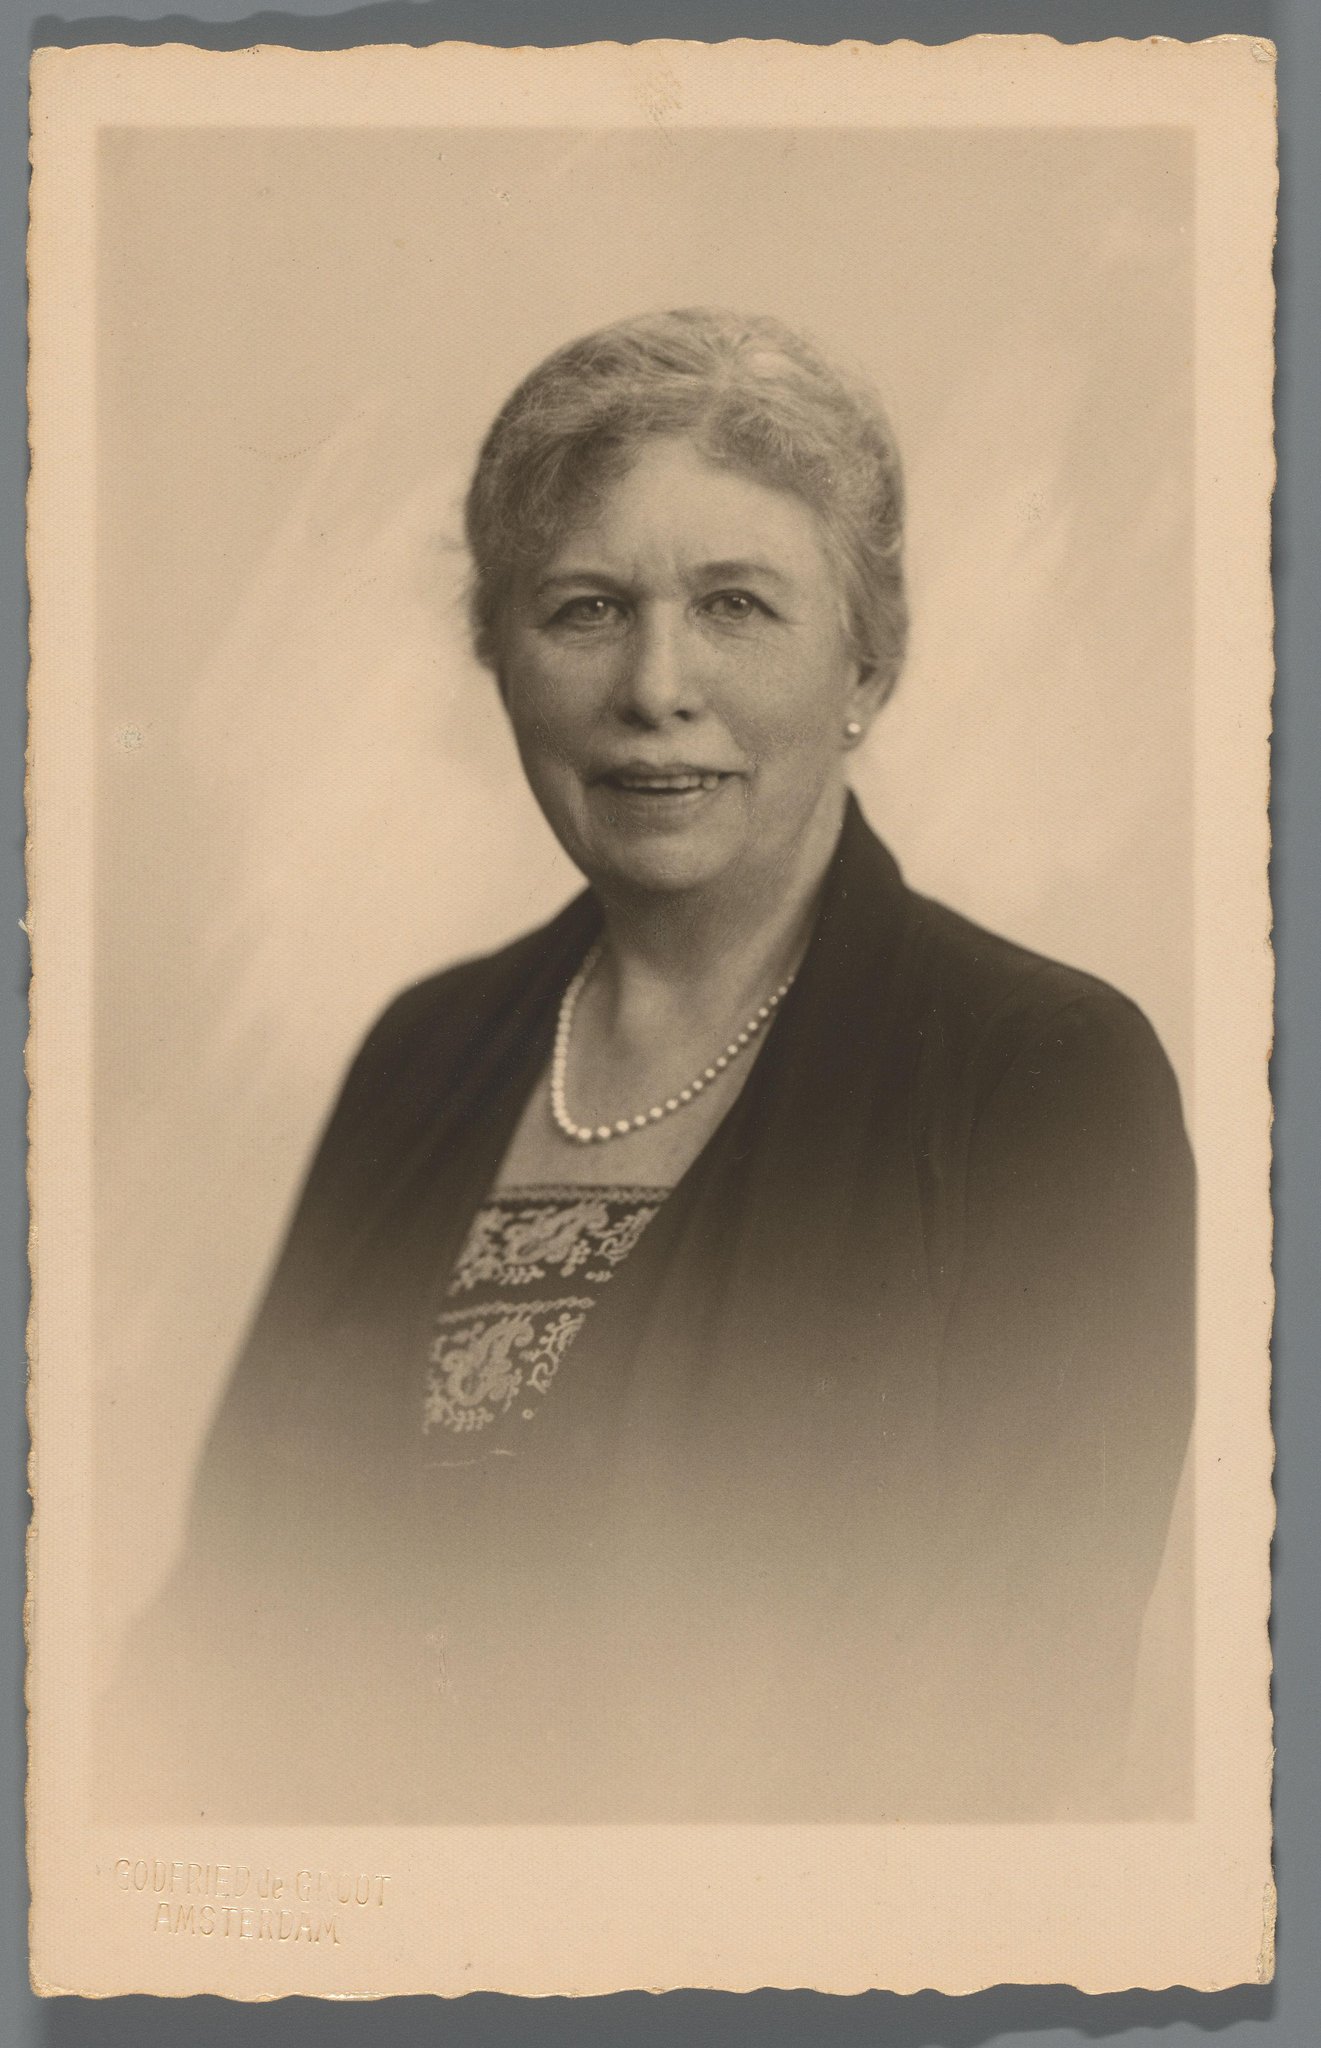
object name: photograph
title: Portret van Poppy Dunlop met parelketting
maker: godfried de groot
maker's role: fotograaf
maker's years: 1894-1963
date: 1900-1940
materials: photographic support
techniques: photography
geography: amsterdam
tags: carolina johanna theofanie bernardine van den berg-dunlop (poppy)